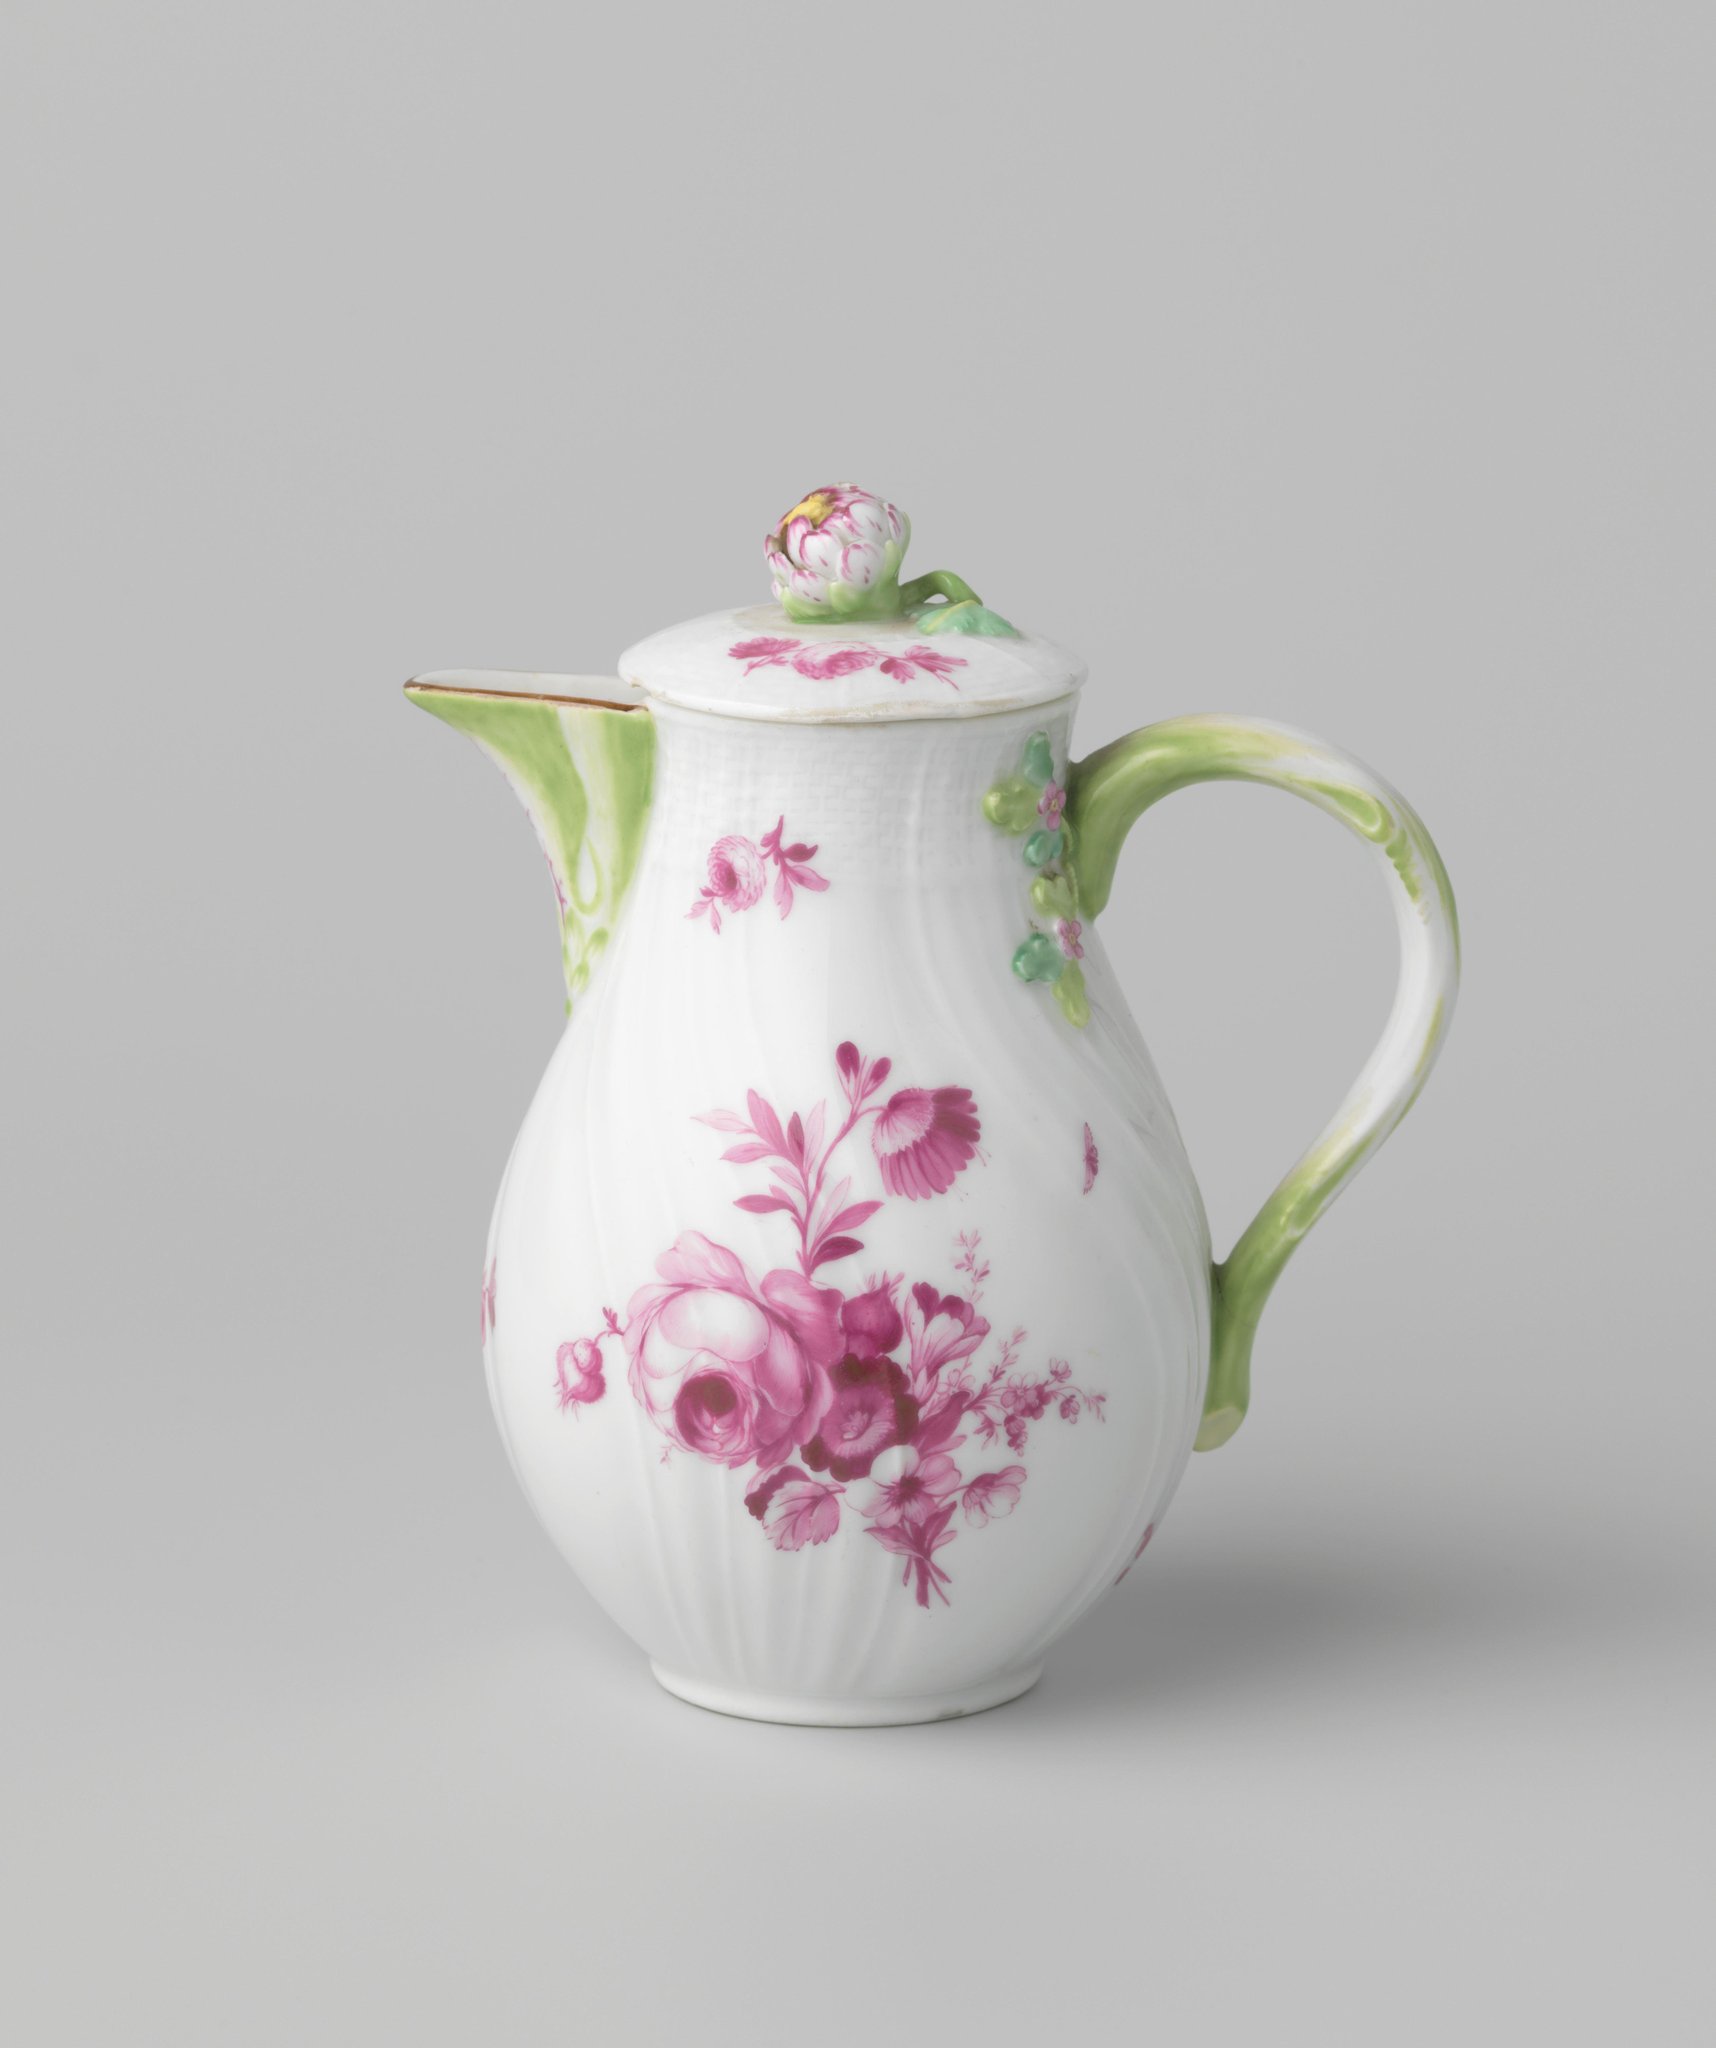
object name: milk jug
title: Cover of milk jug with bouquets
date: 1770-1799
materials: glaze, paint, porcelain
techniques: firing, forming, turning, vitrification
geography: berlin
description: Deksel van een melkkan van porselein, beschilderd op het glazuur in roze, groen en geel. Op de deksel in licht reliëf een weefpatroon met daarop twee bloemtakken in roze camaïeu. Dekselknop in de vorm van een bloem.